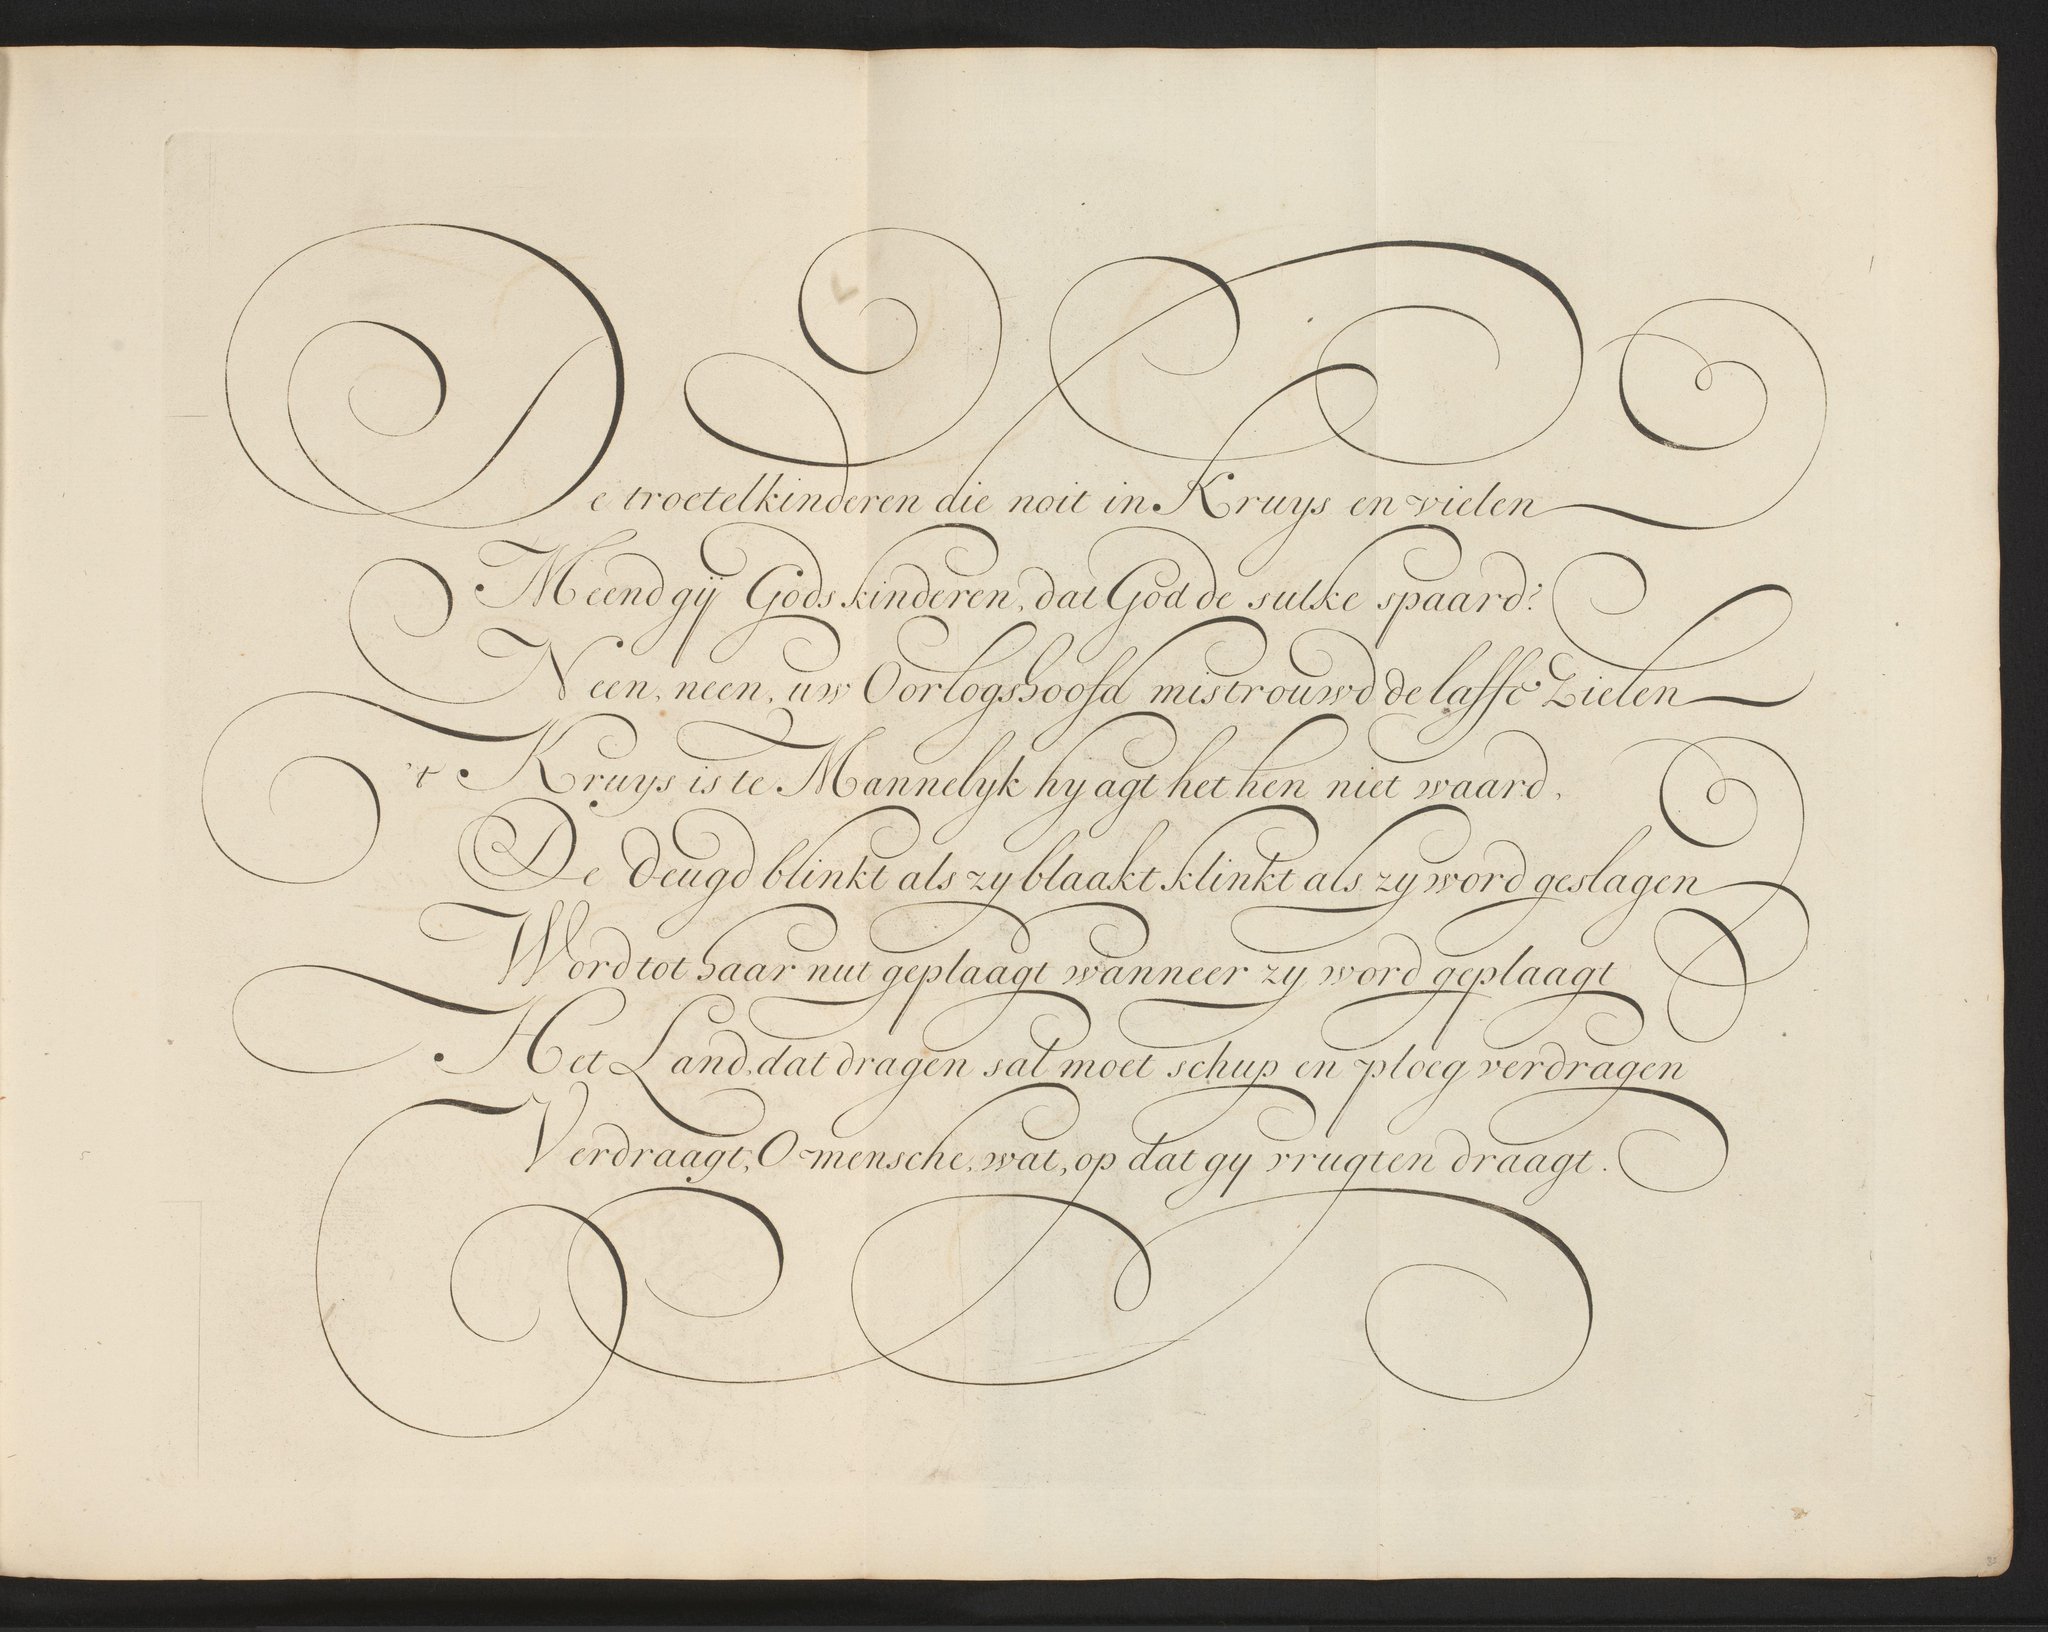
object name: album leaf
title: Schrijfvoorbeeld: De troetelkinderen (...)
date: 1660-1751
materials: paper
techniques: engraving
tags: calligraphy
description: Schrijfvoorbeeld met acht regels tekst in het Nederlands: De troetelkinderen ... De prent maakt deel uit van een album